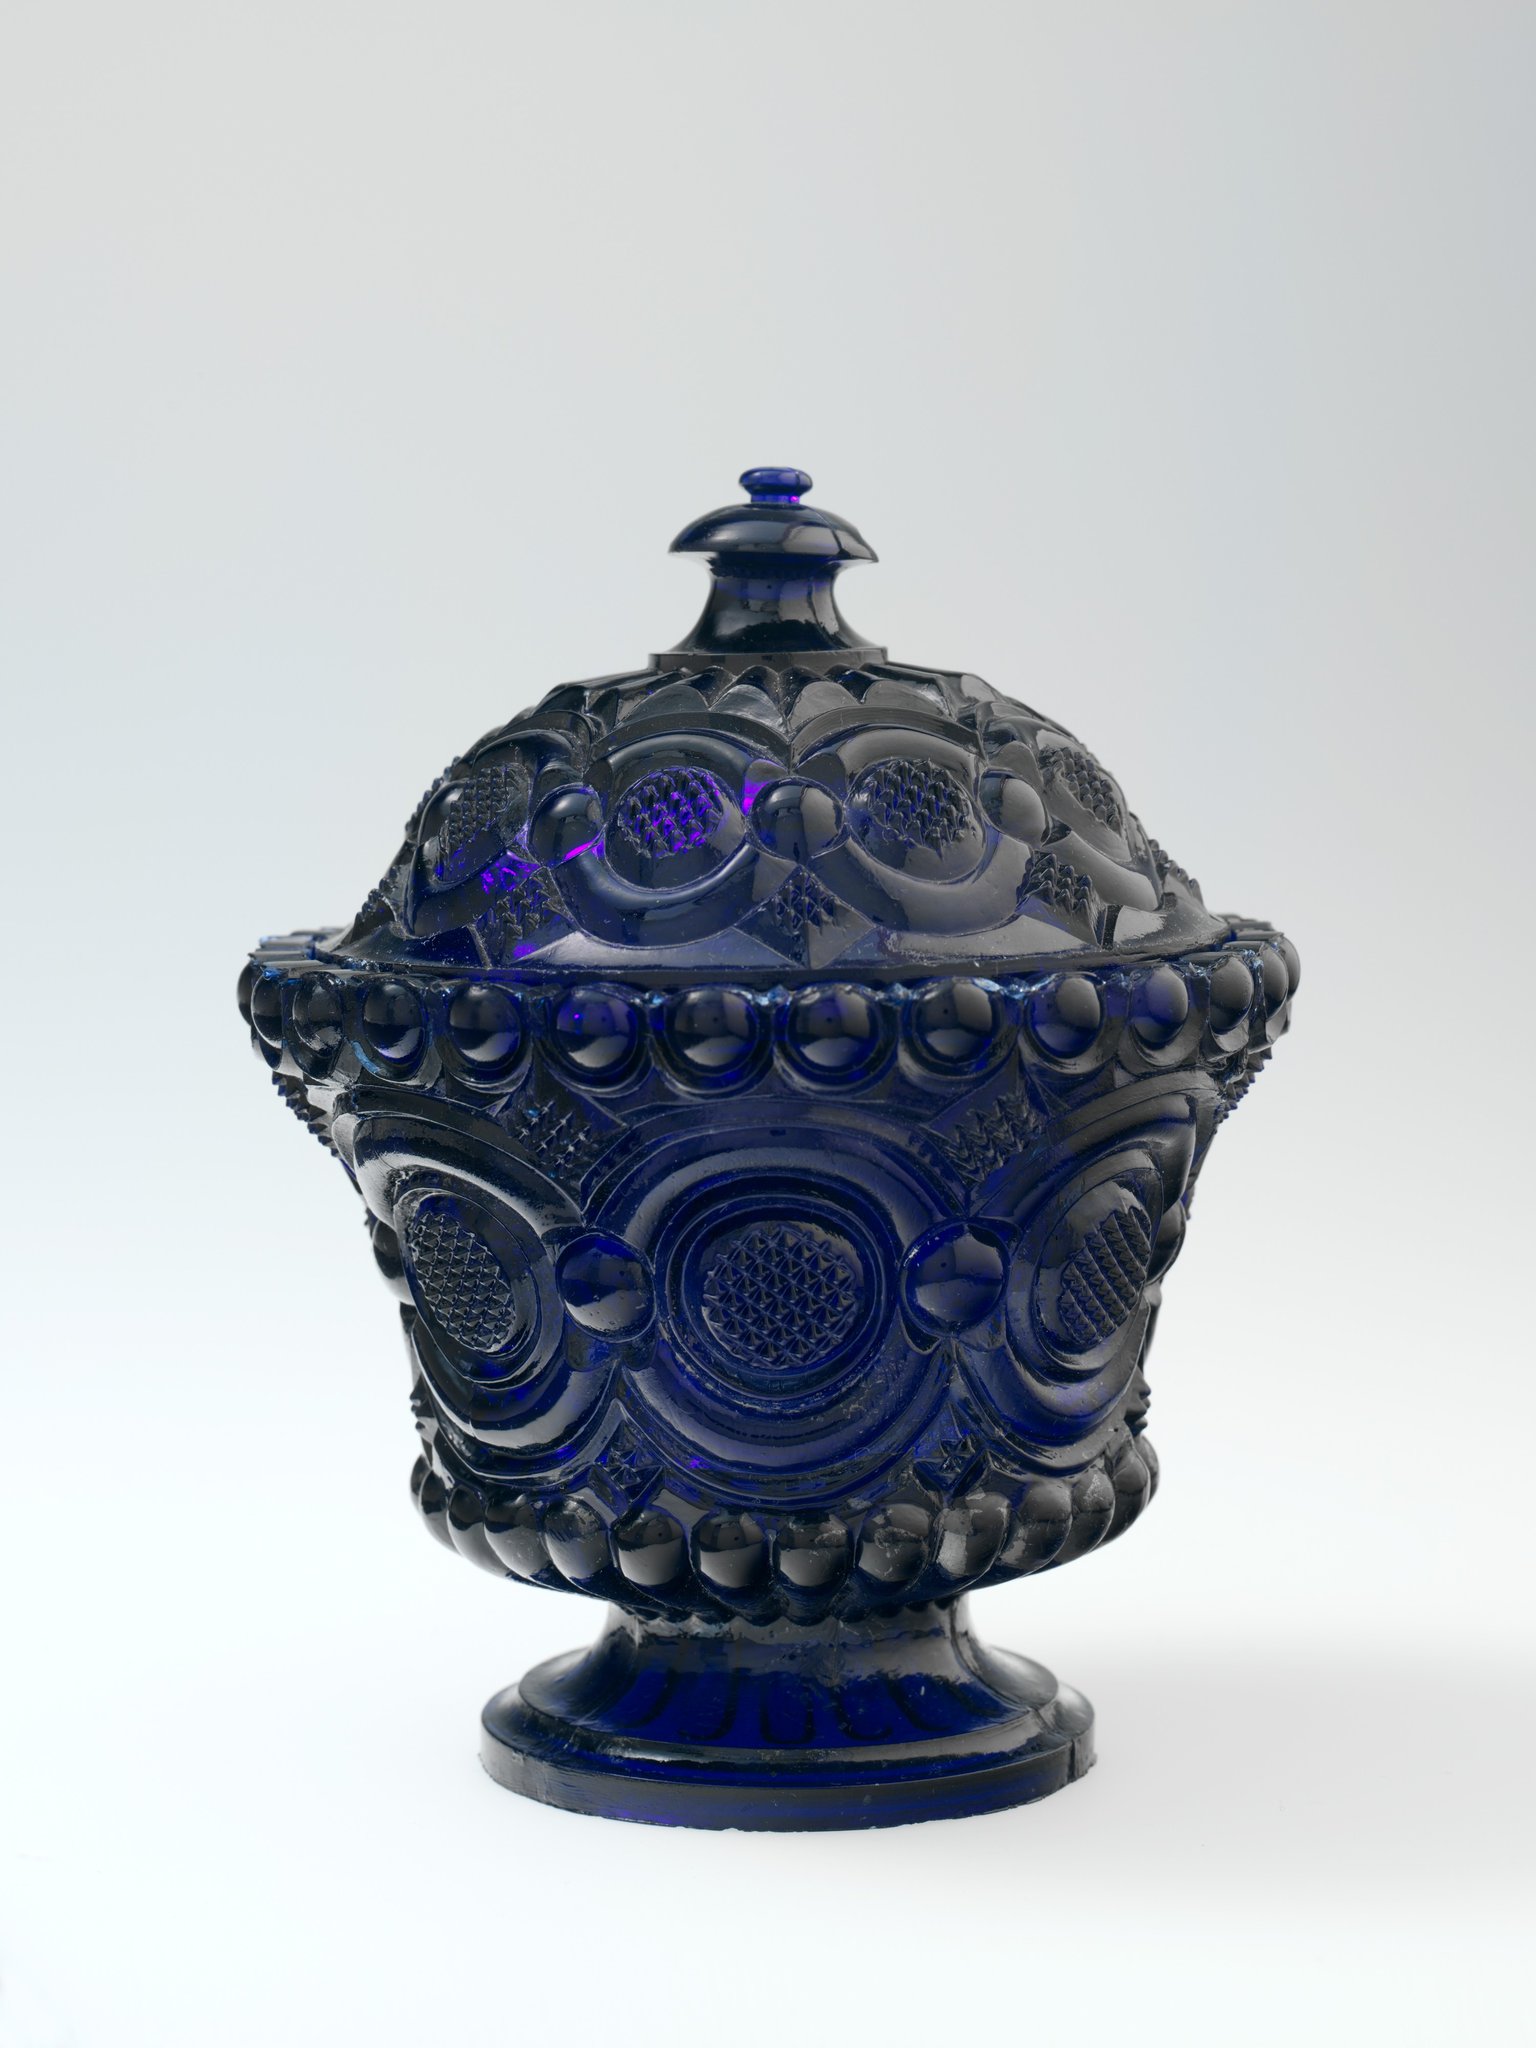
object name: sugar bowl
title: Covered Sugar Bowl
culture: american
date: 1835-1850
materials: glass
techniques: pressed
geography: united states